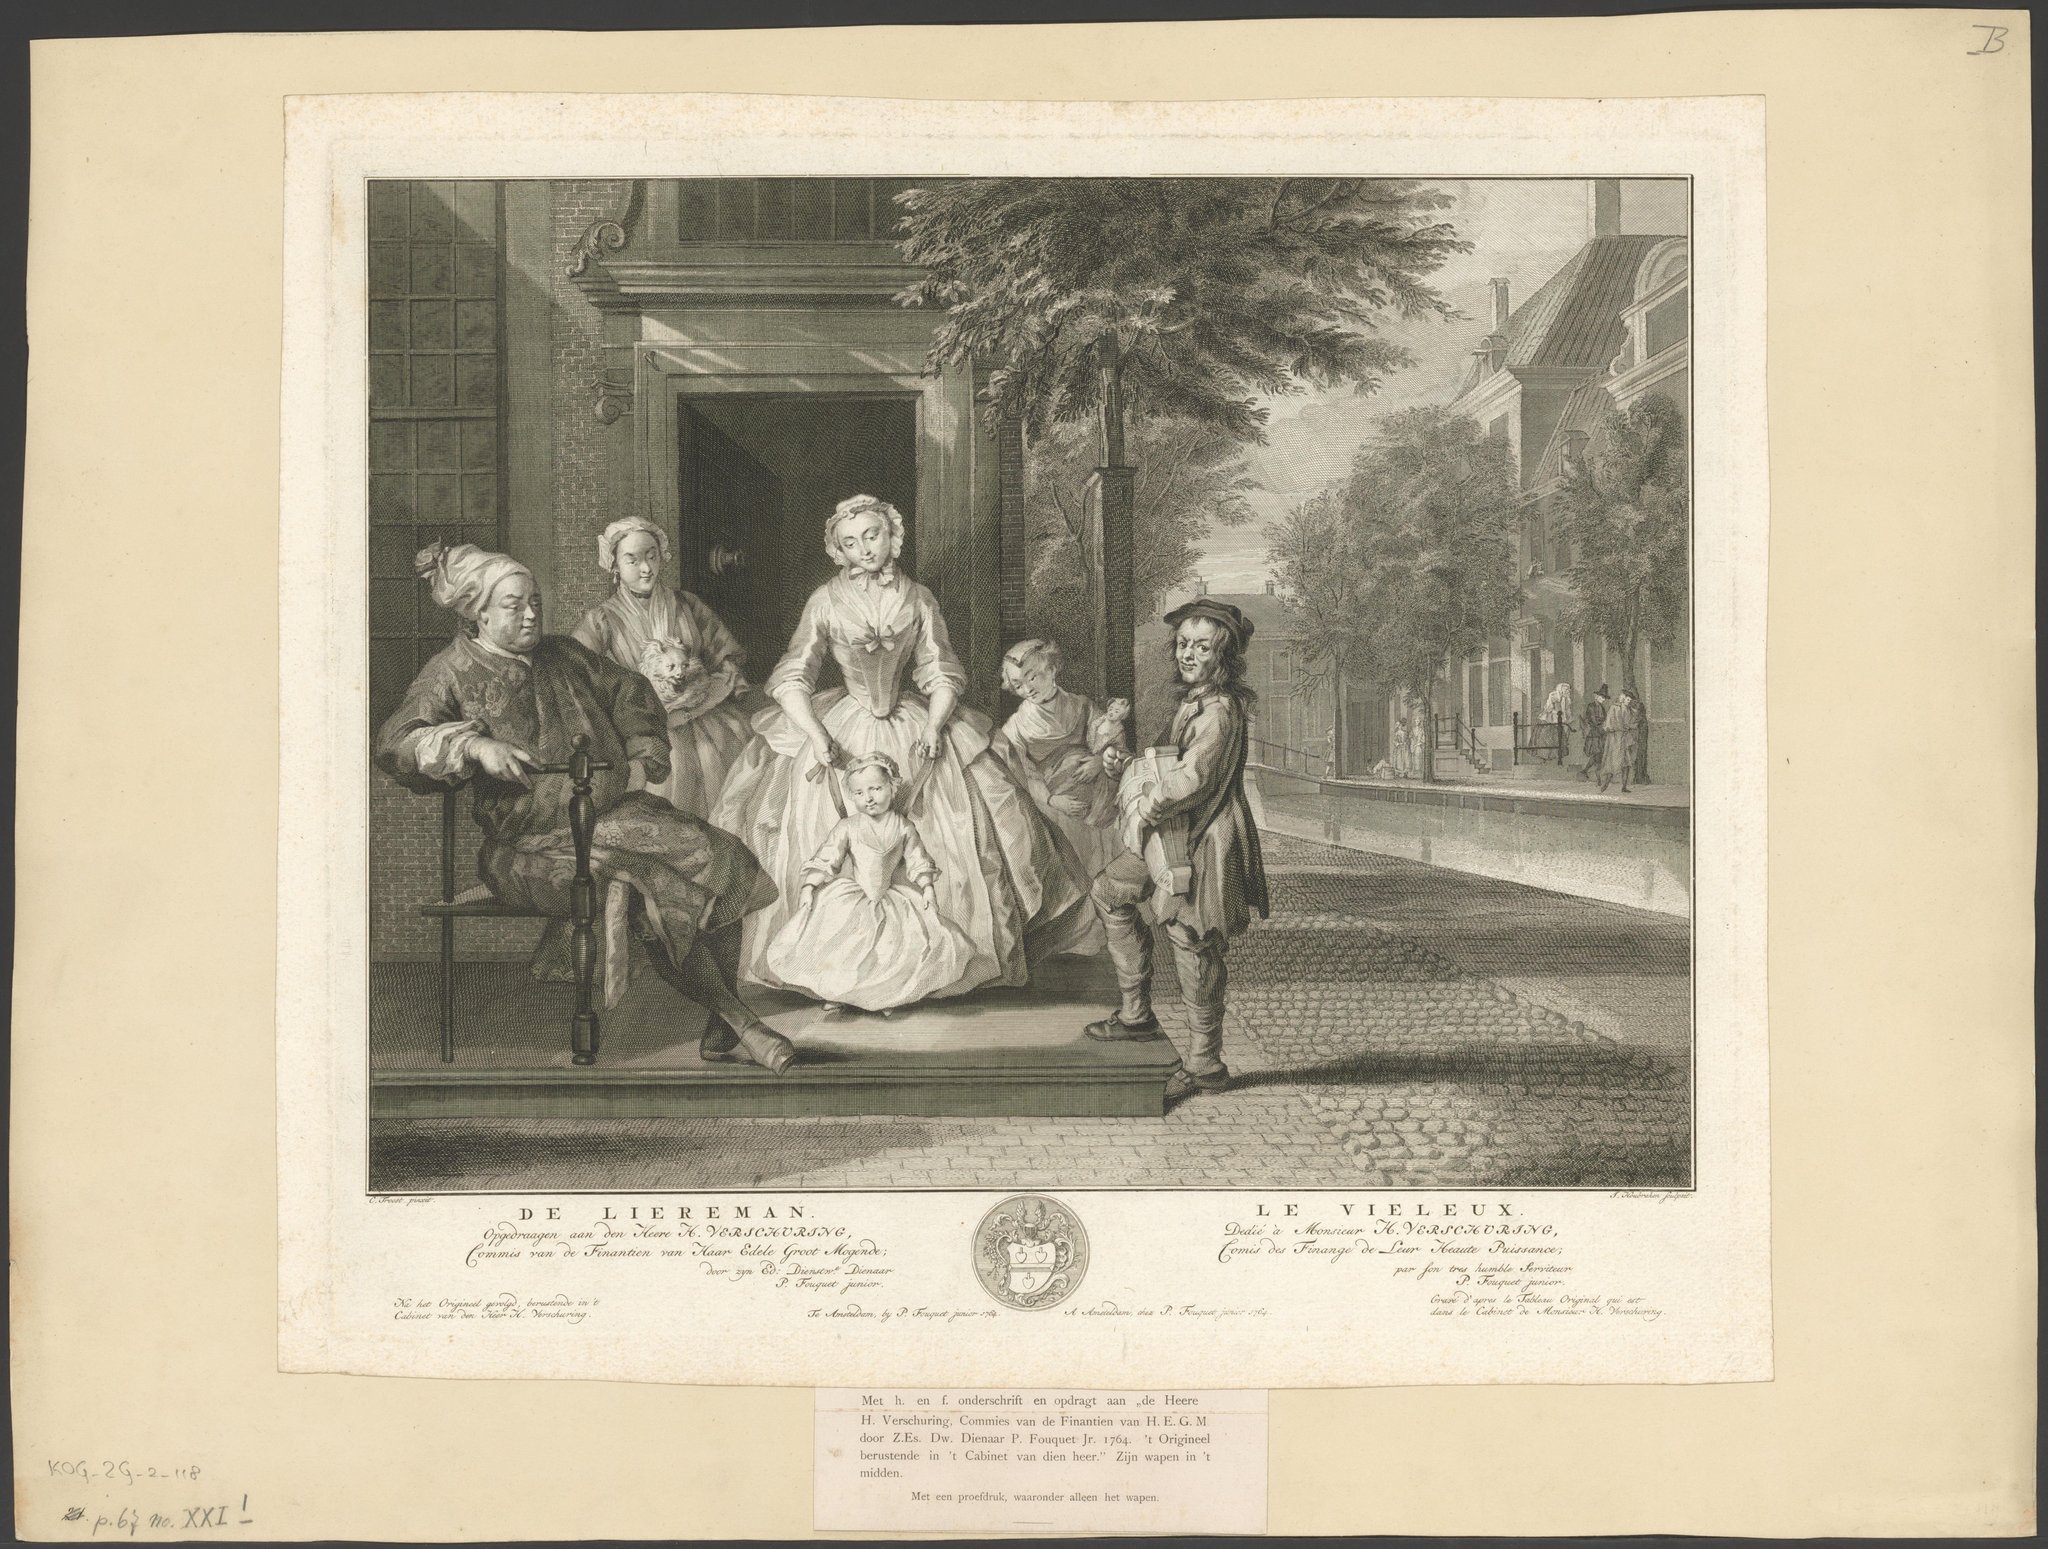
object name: print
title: De Liereman / le Vieleux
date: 1764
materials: paper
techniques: engraving, etching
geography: netherlands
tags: parents with their children, hurdy-gurdy player - cc - out of doors, canals, waters (in city) (+ city(-scape) with figures, staffage)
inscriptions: collector's mark: Lugt 2488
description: Op een stoep voor een deuropening in een stad zit een gezin waaronder twee jonge kinderen. Naast hen staat een straatmuzikant met een draailier. Rechts een gracht.